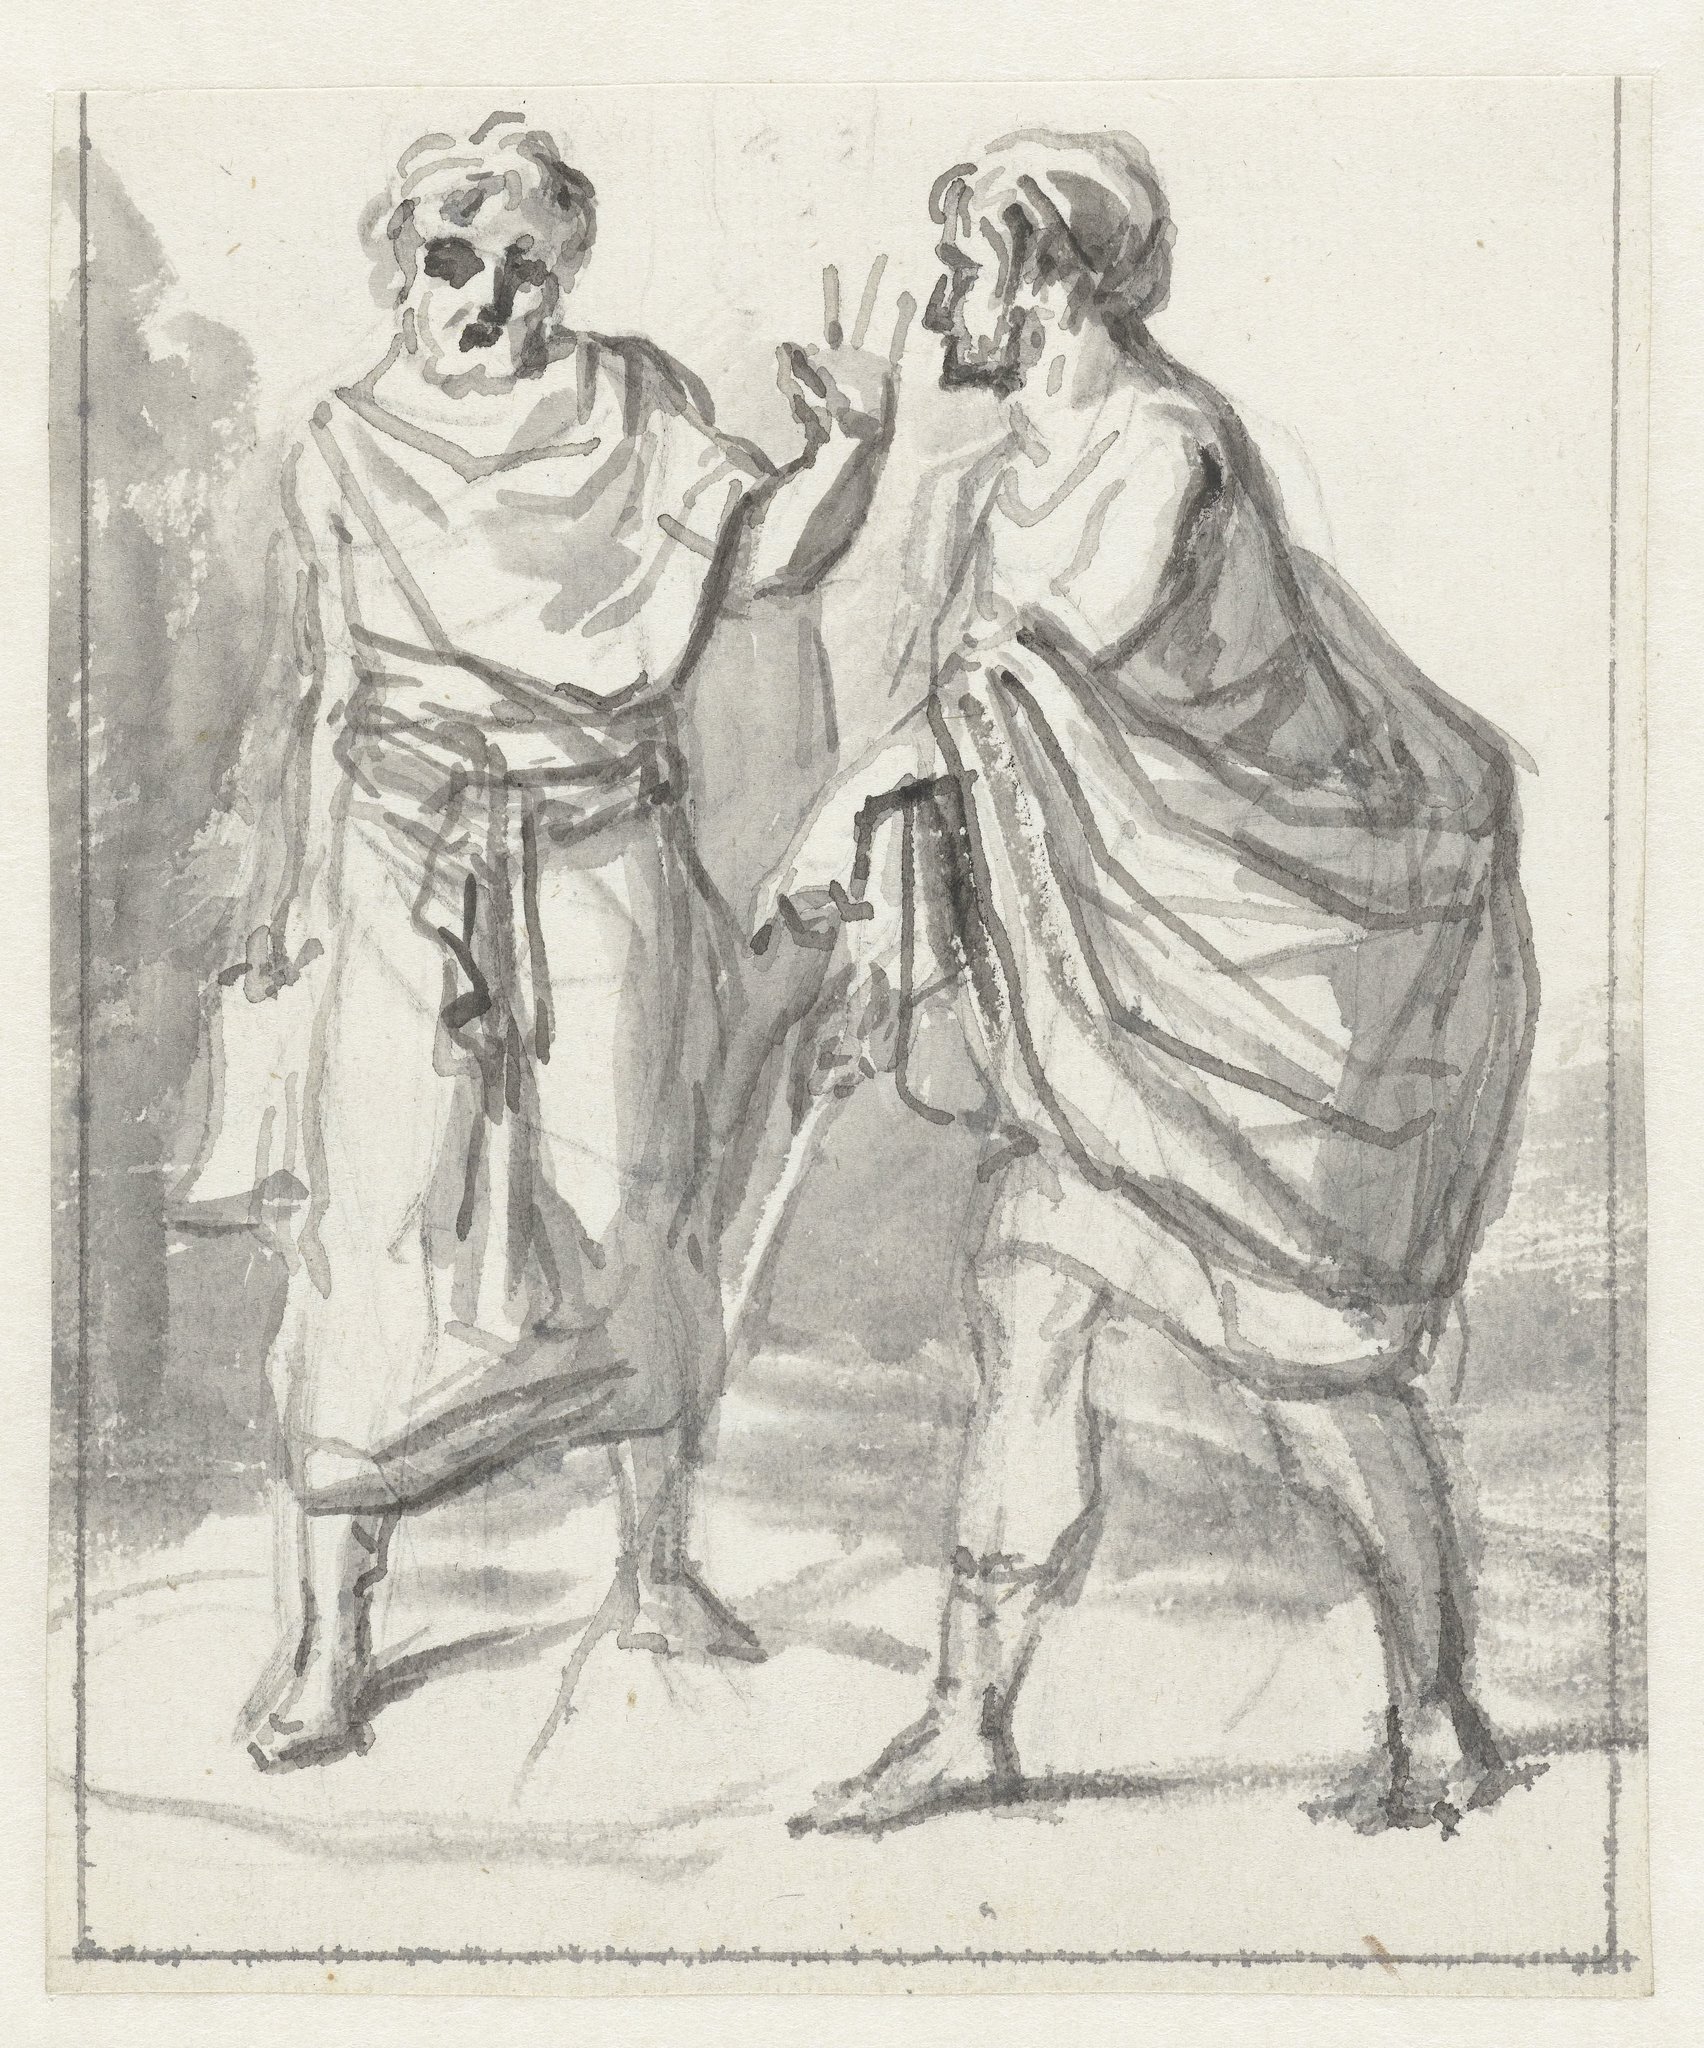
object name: drawing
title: Laenas trekt een cirkel in het zand rond Antiochus IV Epiphanes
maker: jurriaan andriessen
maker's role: draughtsman, painter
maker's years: 1742-1819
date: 1752-1819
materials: graphite, ink, paper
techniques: brush, pen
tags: the consul c. popilius laenas, commissioned by the roman senate to order antiochus iv epiphanes to abstain from war, with his staff draws a circle around the monarch and asks him not to go beyond it before answering